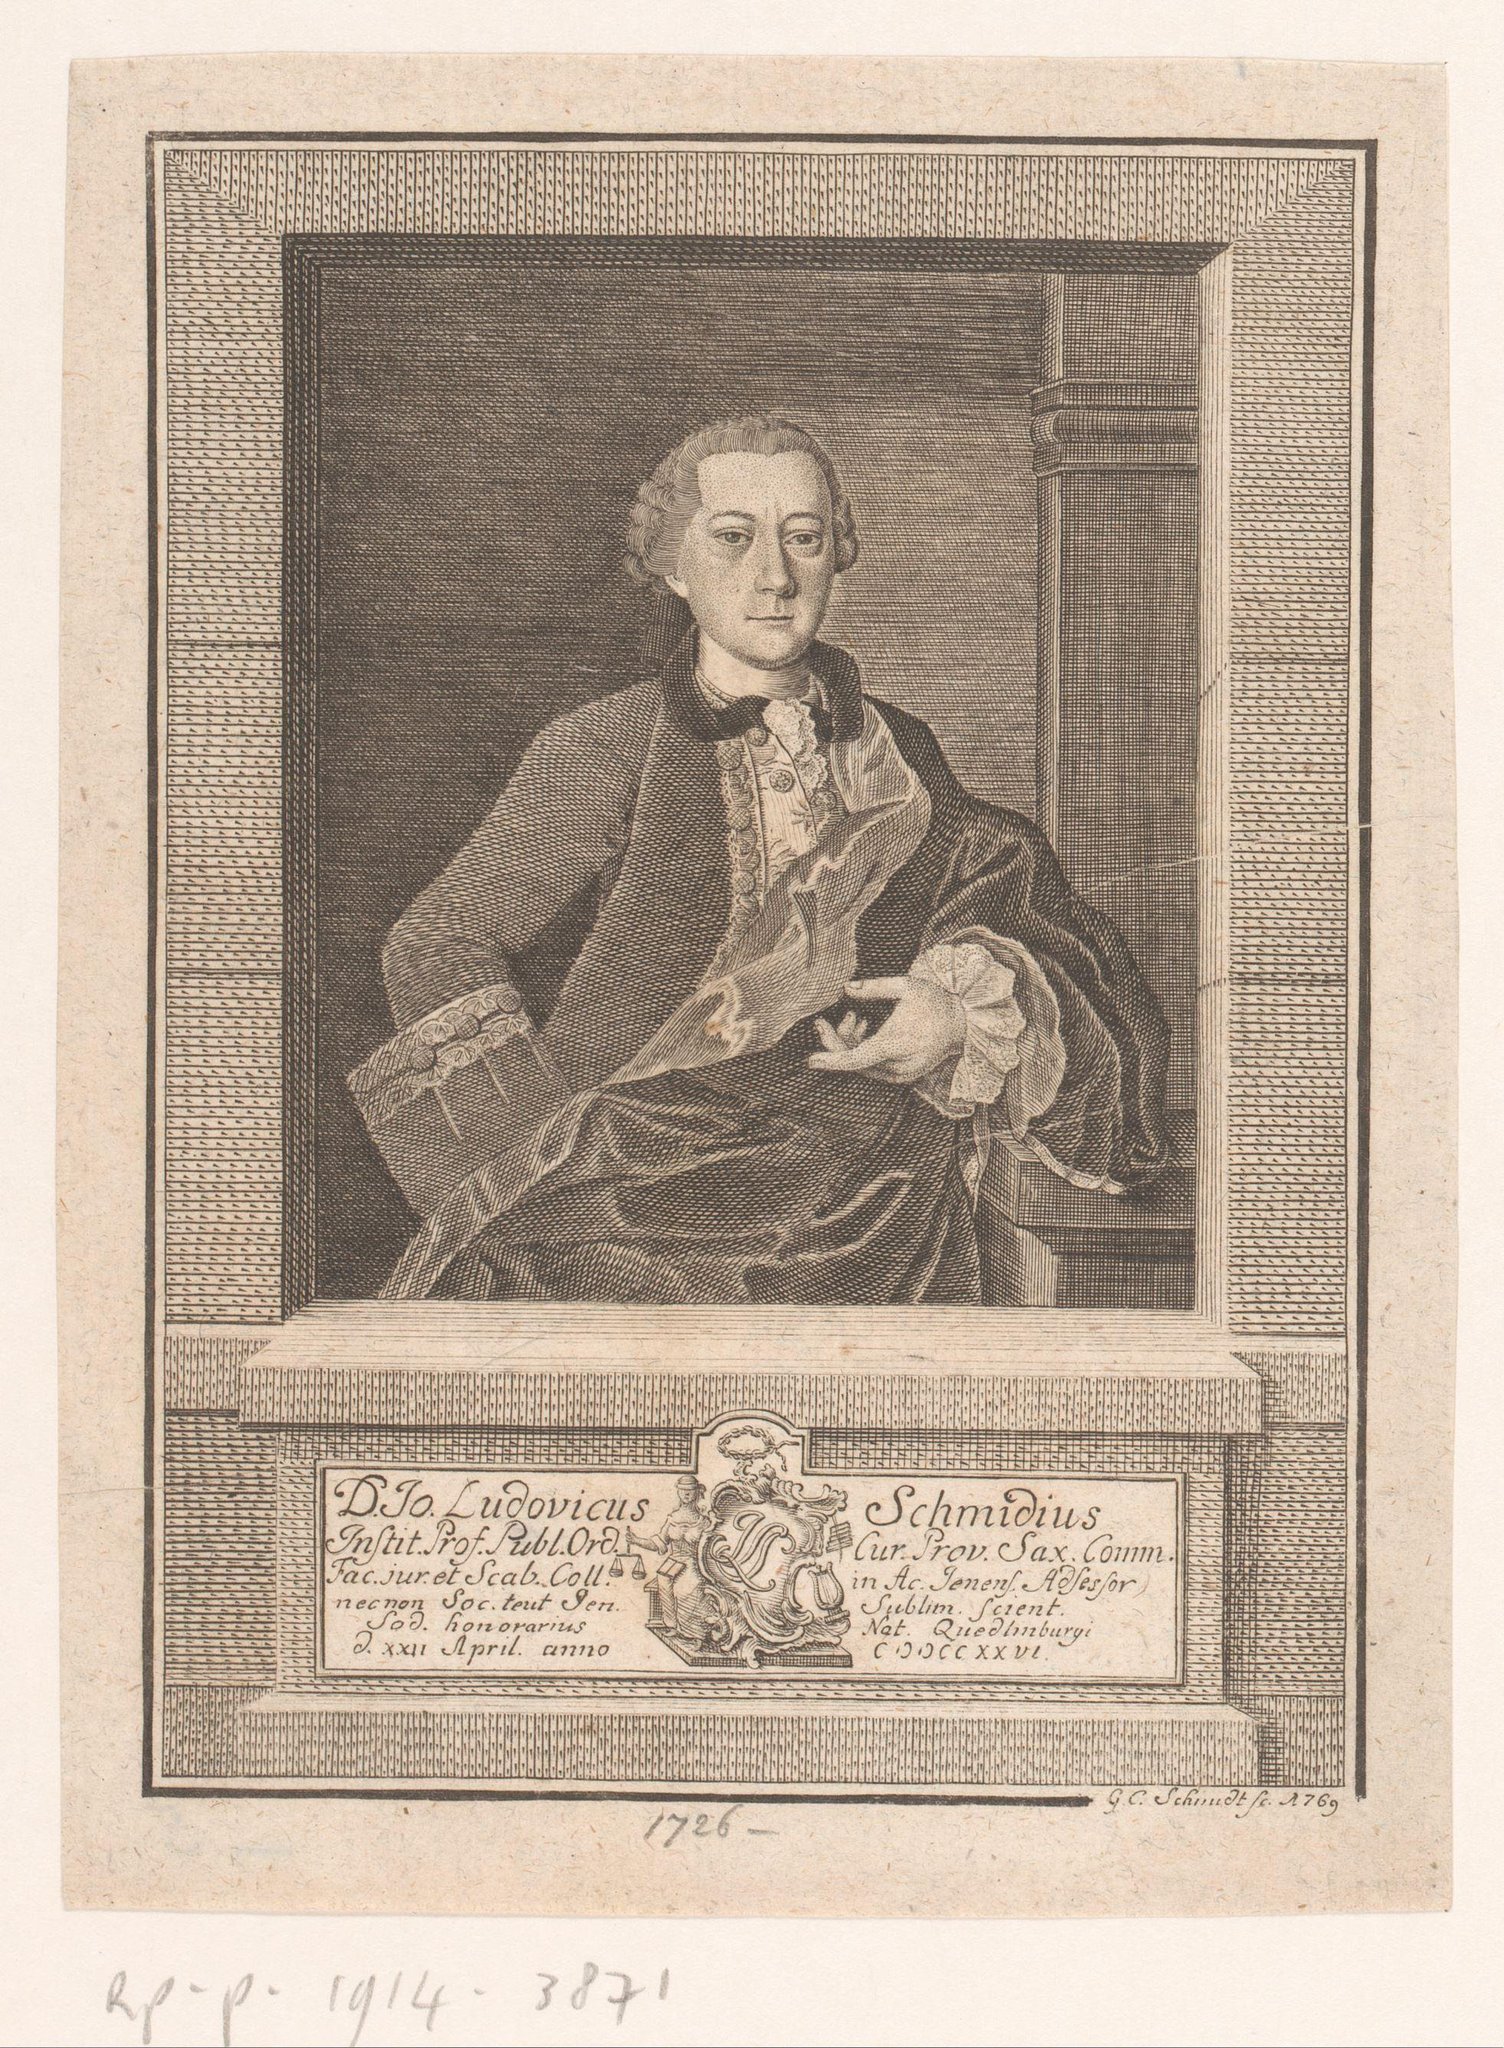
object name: print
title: Portret van Johann Ludwig Schmidt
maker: georg christoph schmidt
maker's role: print maker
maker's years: 1740-1811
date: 1769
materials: paper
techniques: engraving, etching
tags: historical persons, armorial bearing, heraldry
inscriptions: collector's mark: Lugt 2228